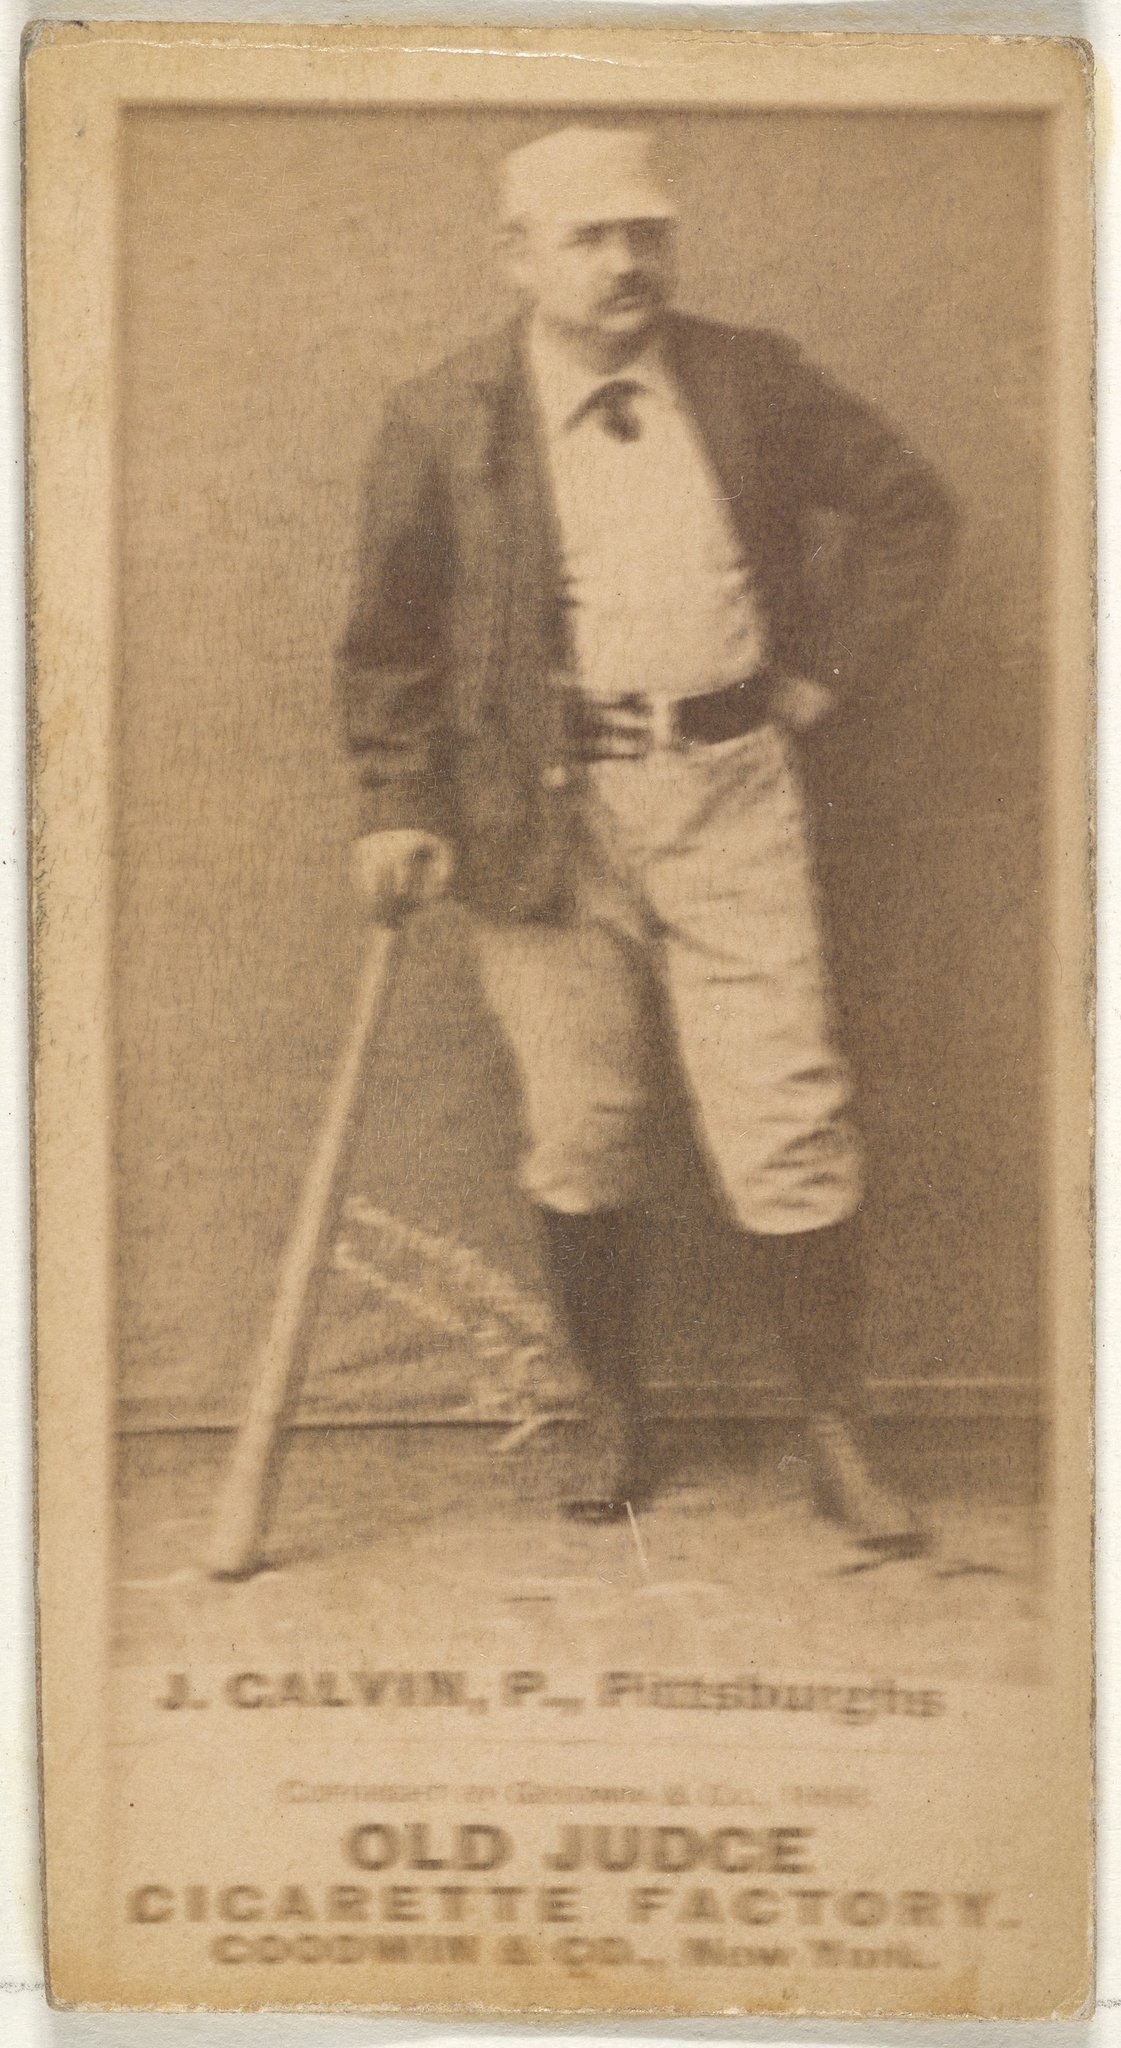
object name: baseball card, photograph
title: James Francis "Pud" Galvin, Pitcher, Pittsburgh, from the Old Judge series (N172) for Old Judge Cigarettes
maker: goodwin & company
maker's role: publisher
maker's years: 1850-1950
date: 1887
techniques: albumen silver print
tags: men,portraits,baseball,athletes